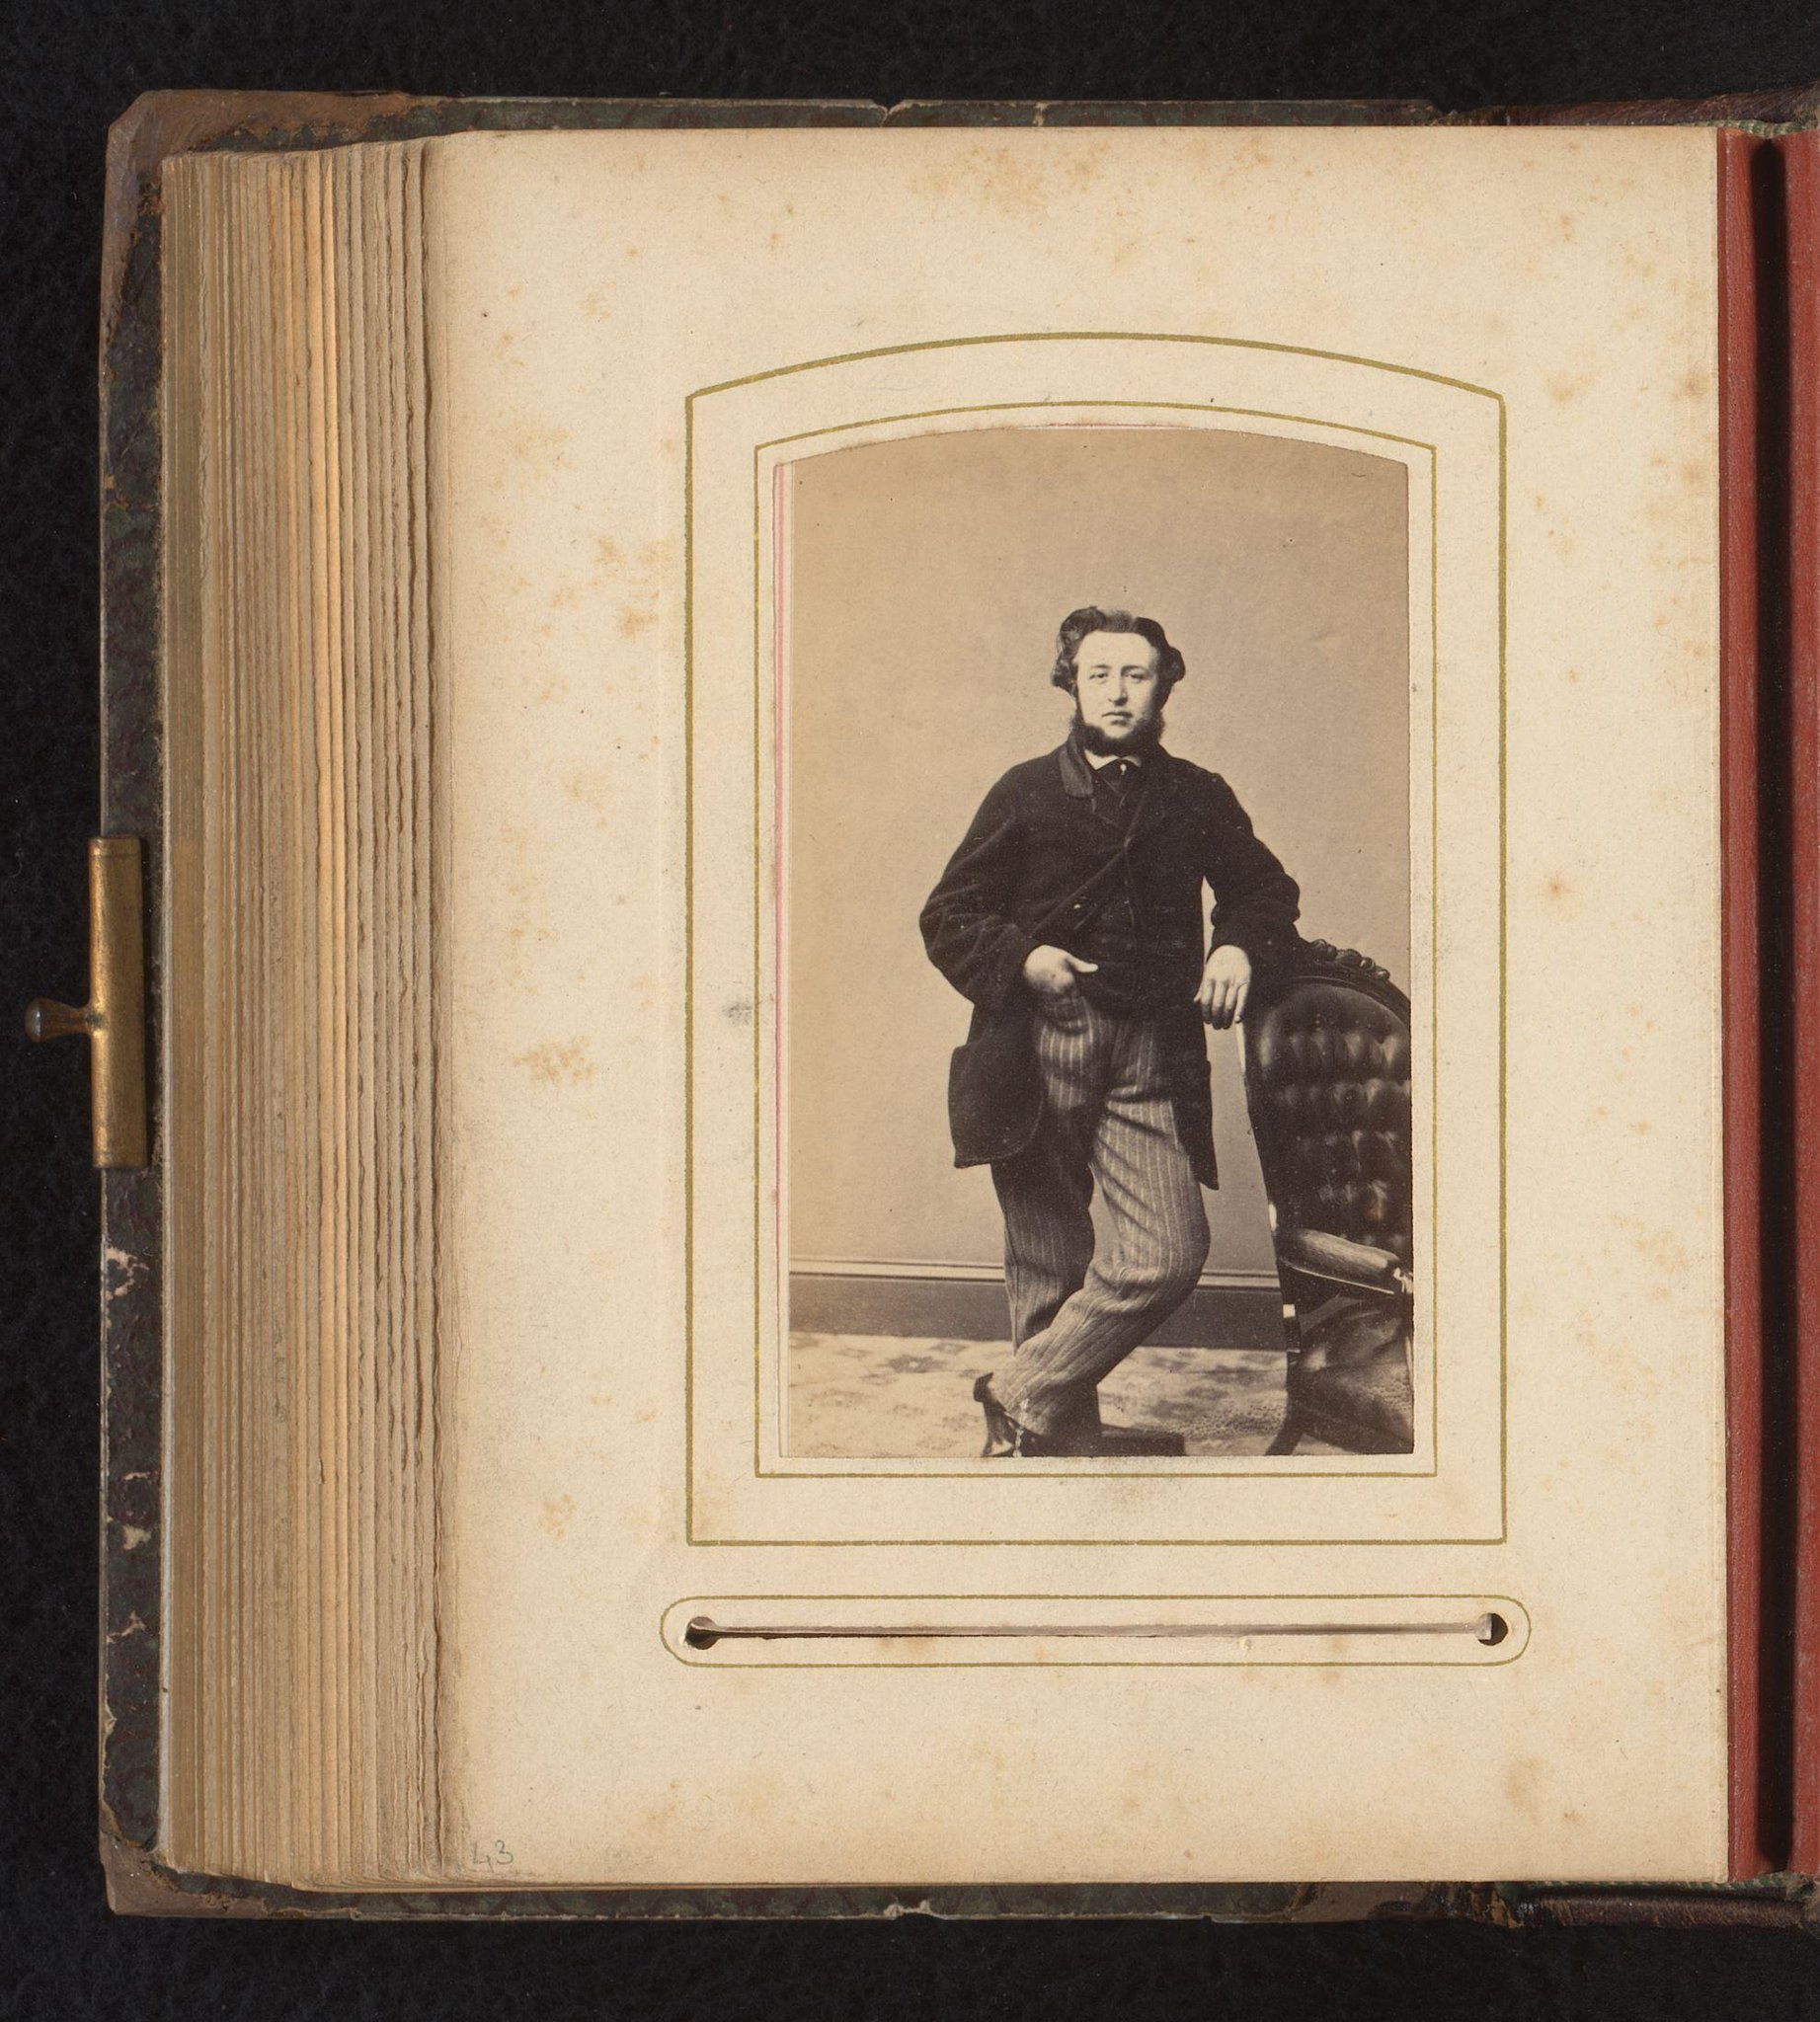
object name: carte de visite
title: Portret van een man met baard bij een stoel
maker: richard a. lewis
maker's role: fotograaf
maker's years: 1820-1891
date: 1860-1900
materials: cardboard, photographic support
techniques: albumen print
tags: adult man, historical persons, chair, beard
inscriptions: inscription: ‘R. A. Lewis/ 160 Chatham Street/ (...)’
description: Op verso is een Amerikaanse postzegel geplakt.